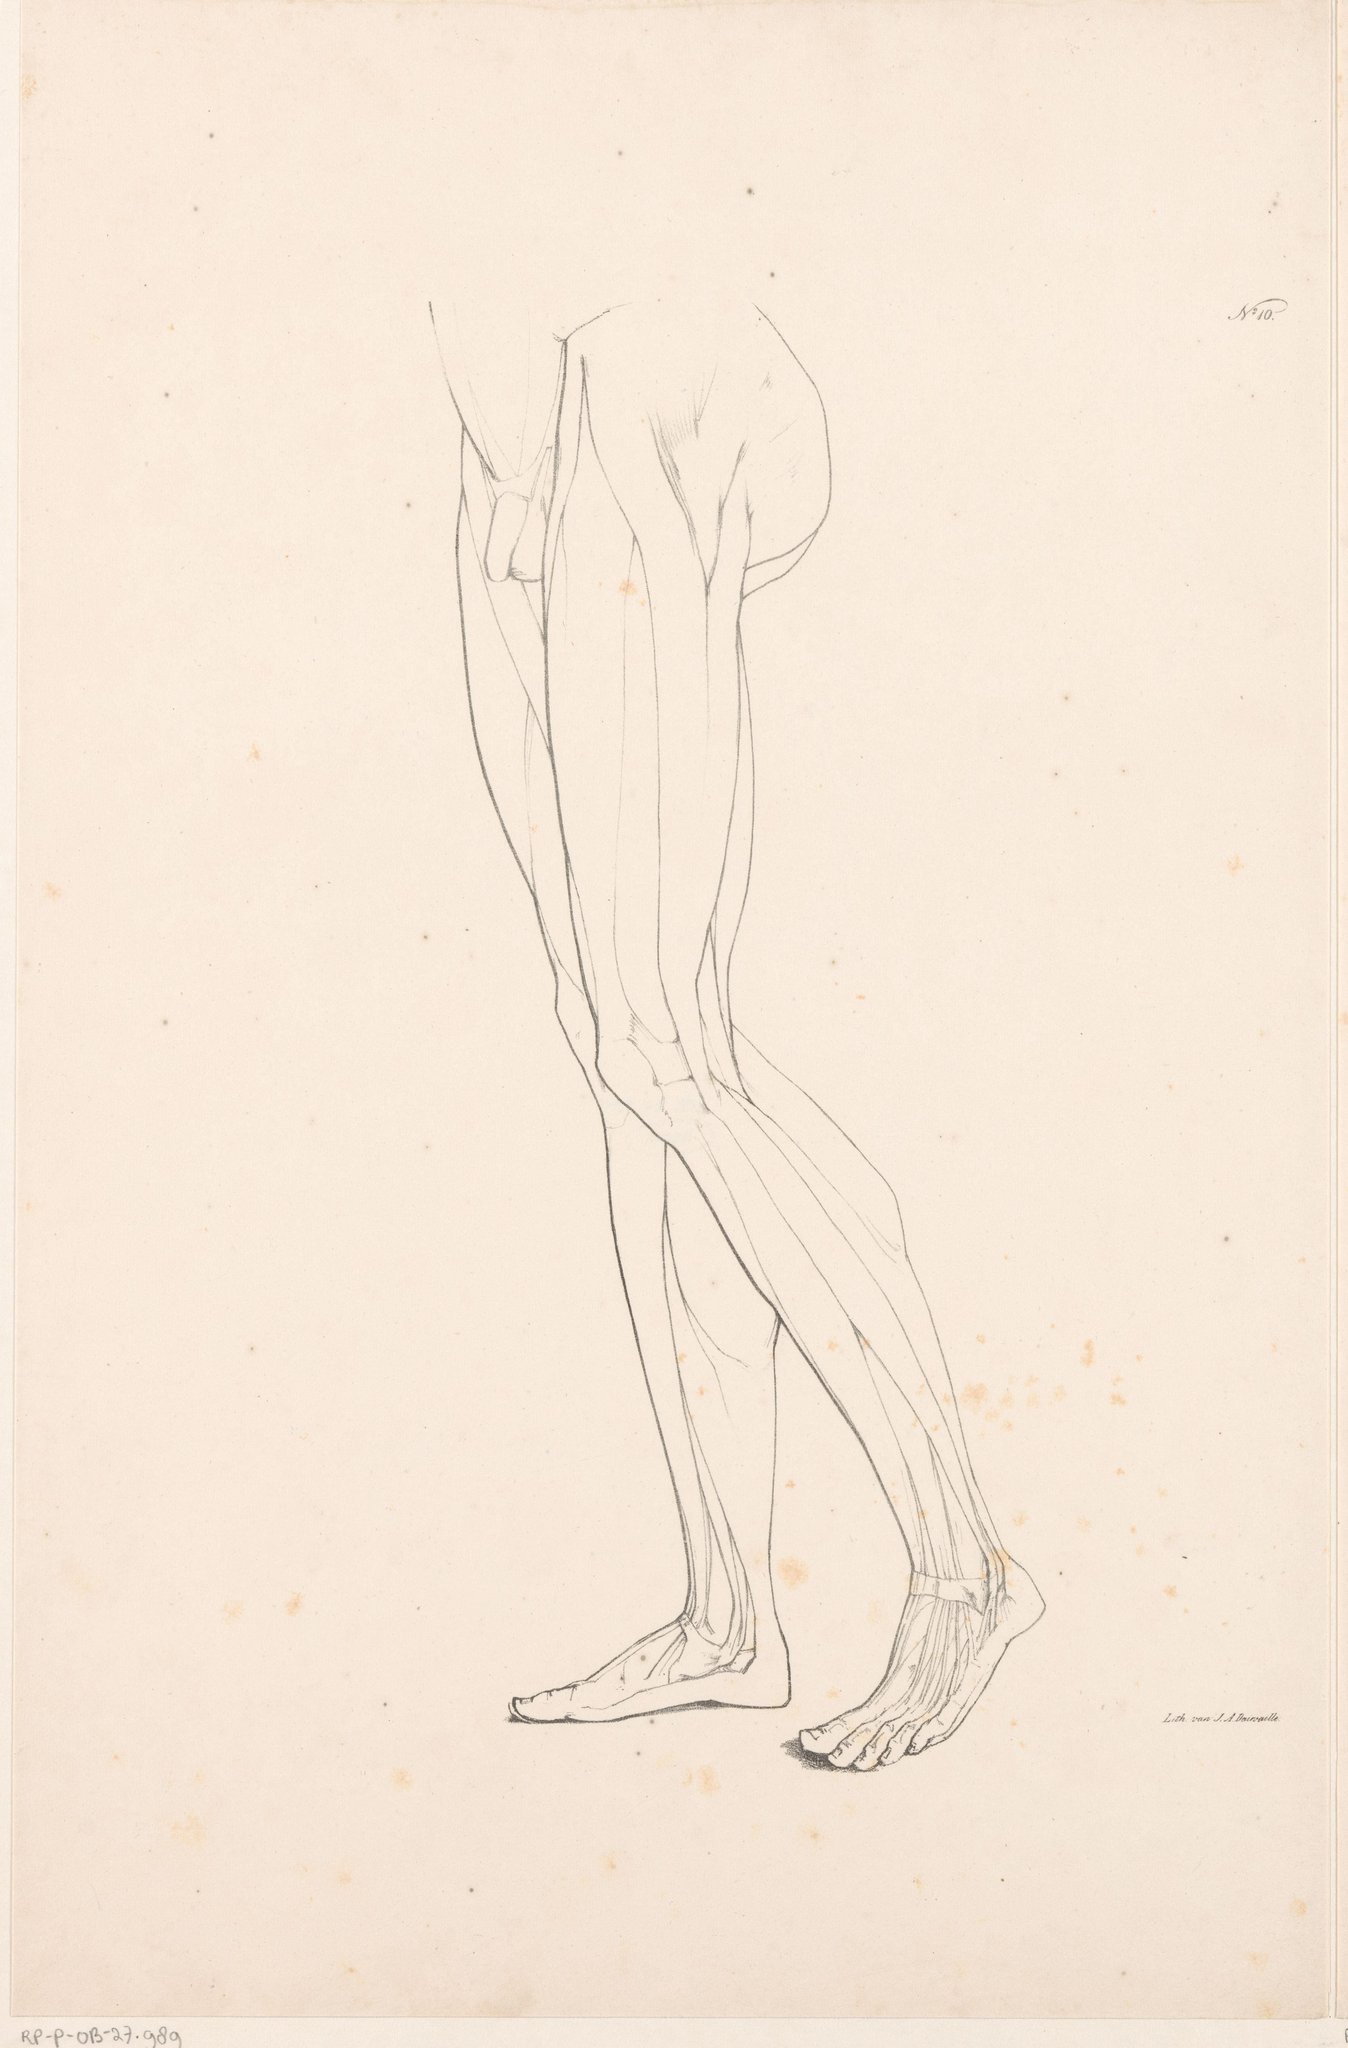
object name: print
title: Twee benen met spierbundels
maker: jean augustin daiwaille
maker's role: draughtsman, print maker, printer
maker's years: 1786-1850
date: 1820-1833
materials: paper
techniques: lithograph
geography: amsterdam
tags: standing on one leg, the other leg backwards, muscles, anatomical model of the muscles, muscle-man, 'écorché'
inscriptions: collector's mark: Lugt 2228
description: De linkervoet raakt alleen met de tenen de grond. Genummerd rechtsboven: 'No. 10'.